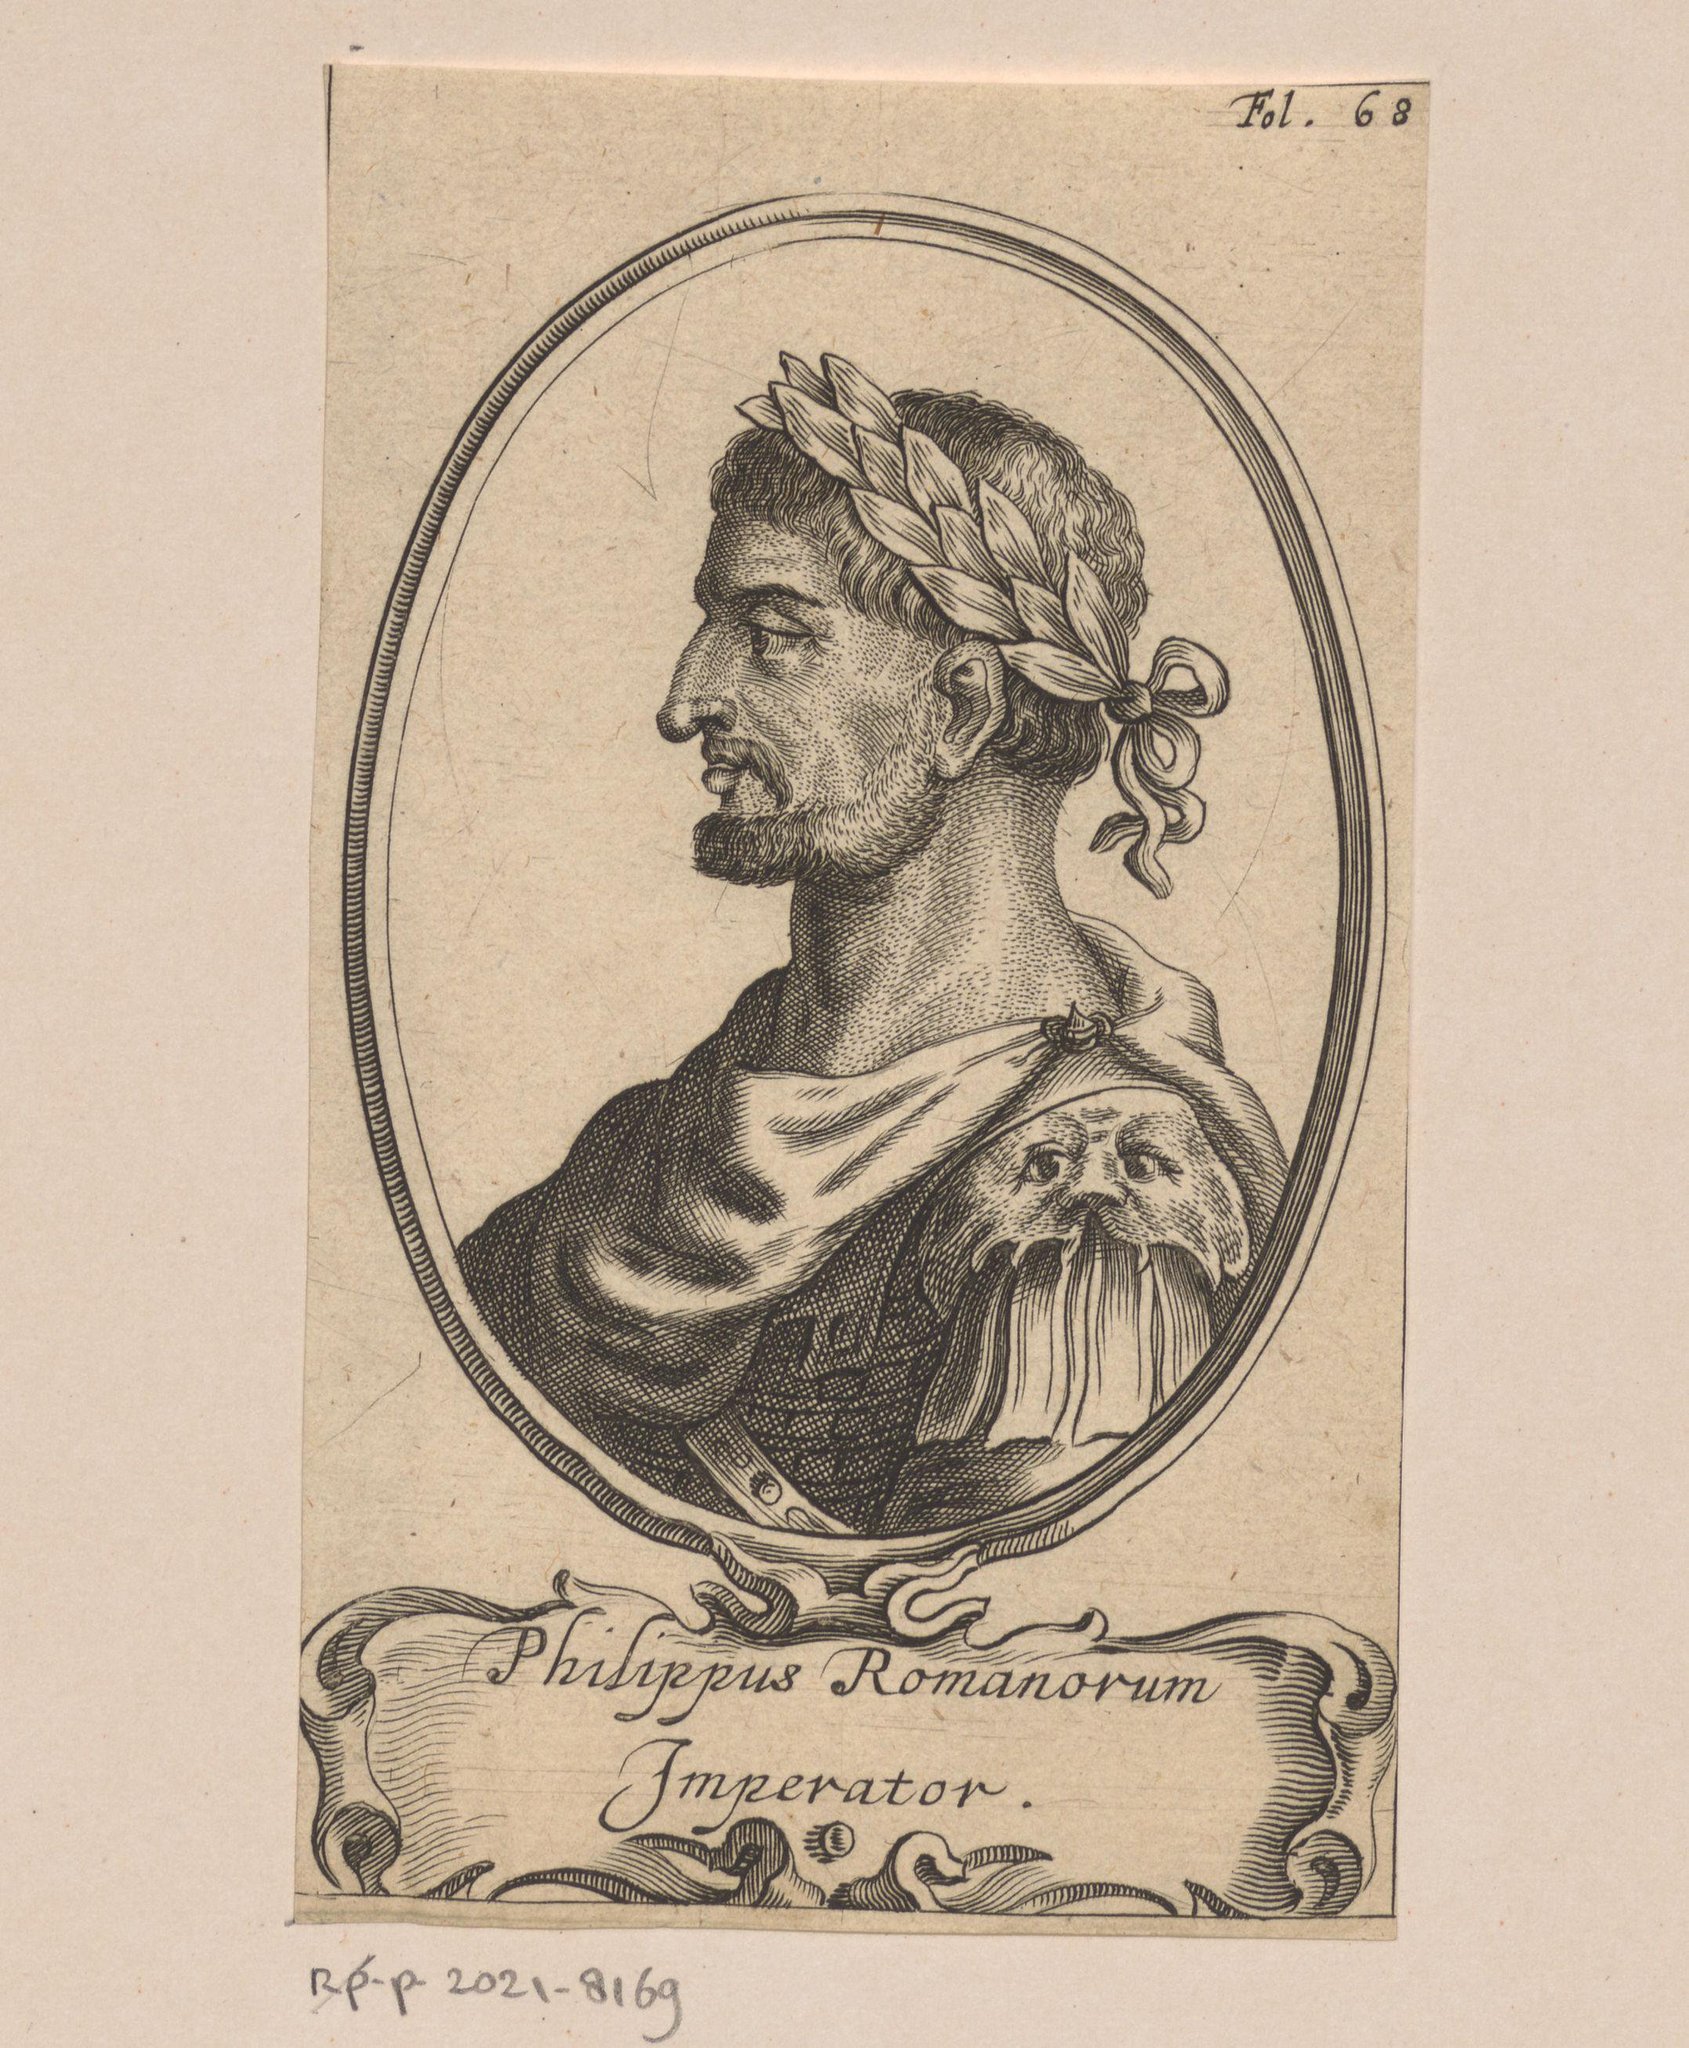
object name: print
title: Portret van Philippus II, keizer van het Romeinse Rijk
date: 1656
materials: paper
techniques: engraving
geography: dordrecht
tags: adult man, historical persons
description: Prent uit: Bos, Lambert van den. Het konincklyk treur-toonneel, ofte op- en ondergangh der keyseren, koningen en vorsten (...). Dordrecht: Jacobus Savry, 1656, dl. 1.